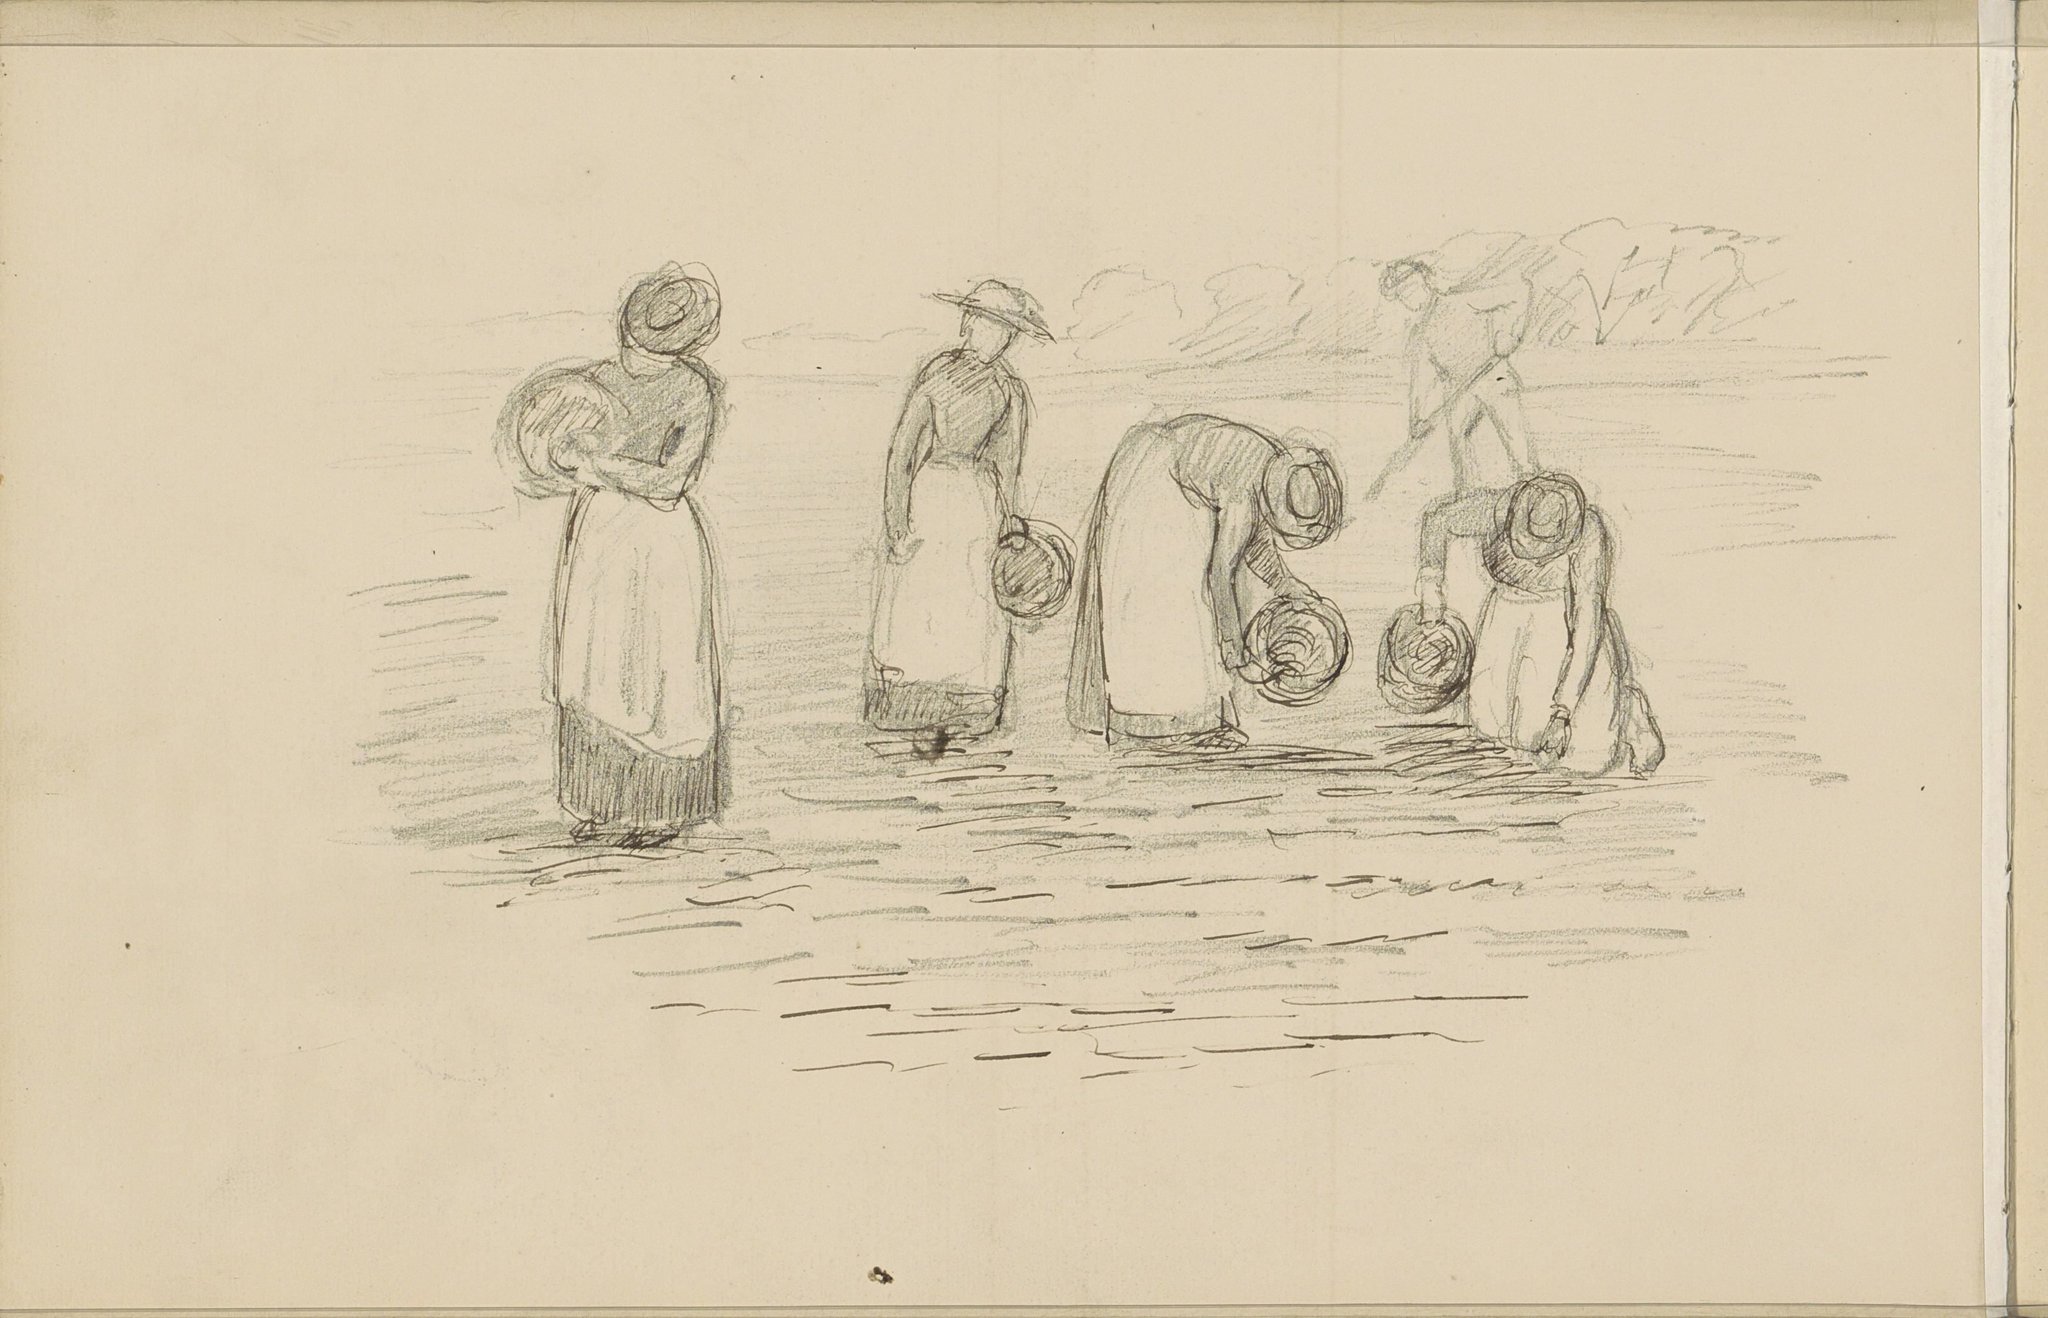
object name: sketchbook leaf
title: Vier vrouwen die aardappels rapen op een akker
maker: jozef israëls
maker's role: draughtsman, painter, print maker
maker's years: 1824-1911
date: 1834-1911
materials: ink, paper, pencil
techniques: pen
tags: reaping, picking, mowing ~ harvest (+ women (labourers)), container made of plant material other than wood: basket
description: De vrouwen dragen rieten manden. Op de achtergrond een man met een stuk landbouwgereedschap. Blad 14 verso uit een schetsboek met 25 bladen.